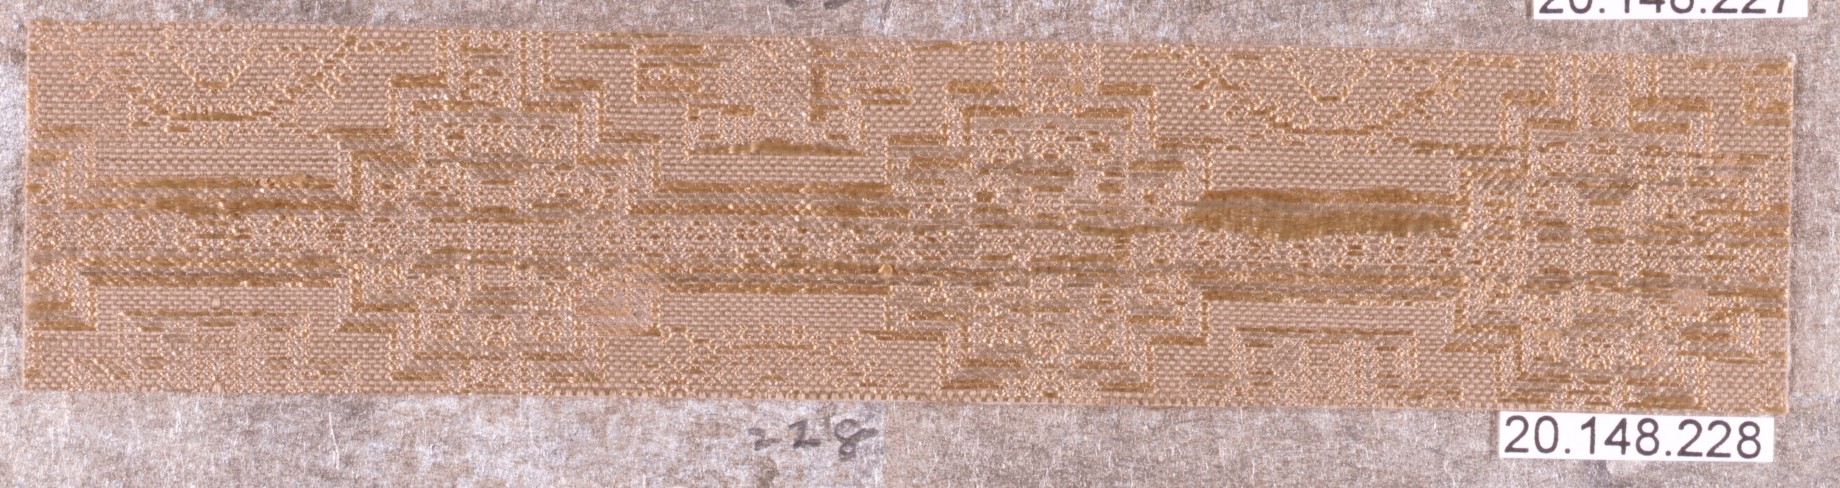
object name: piece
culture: japanese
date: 1701-1800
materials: silk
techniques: compound weave